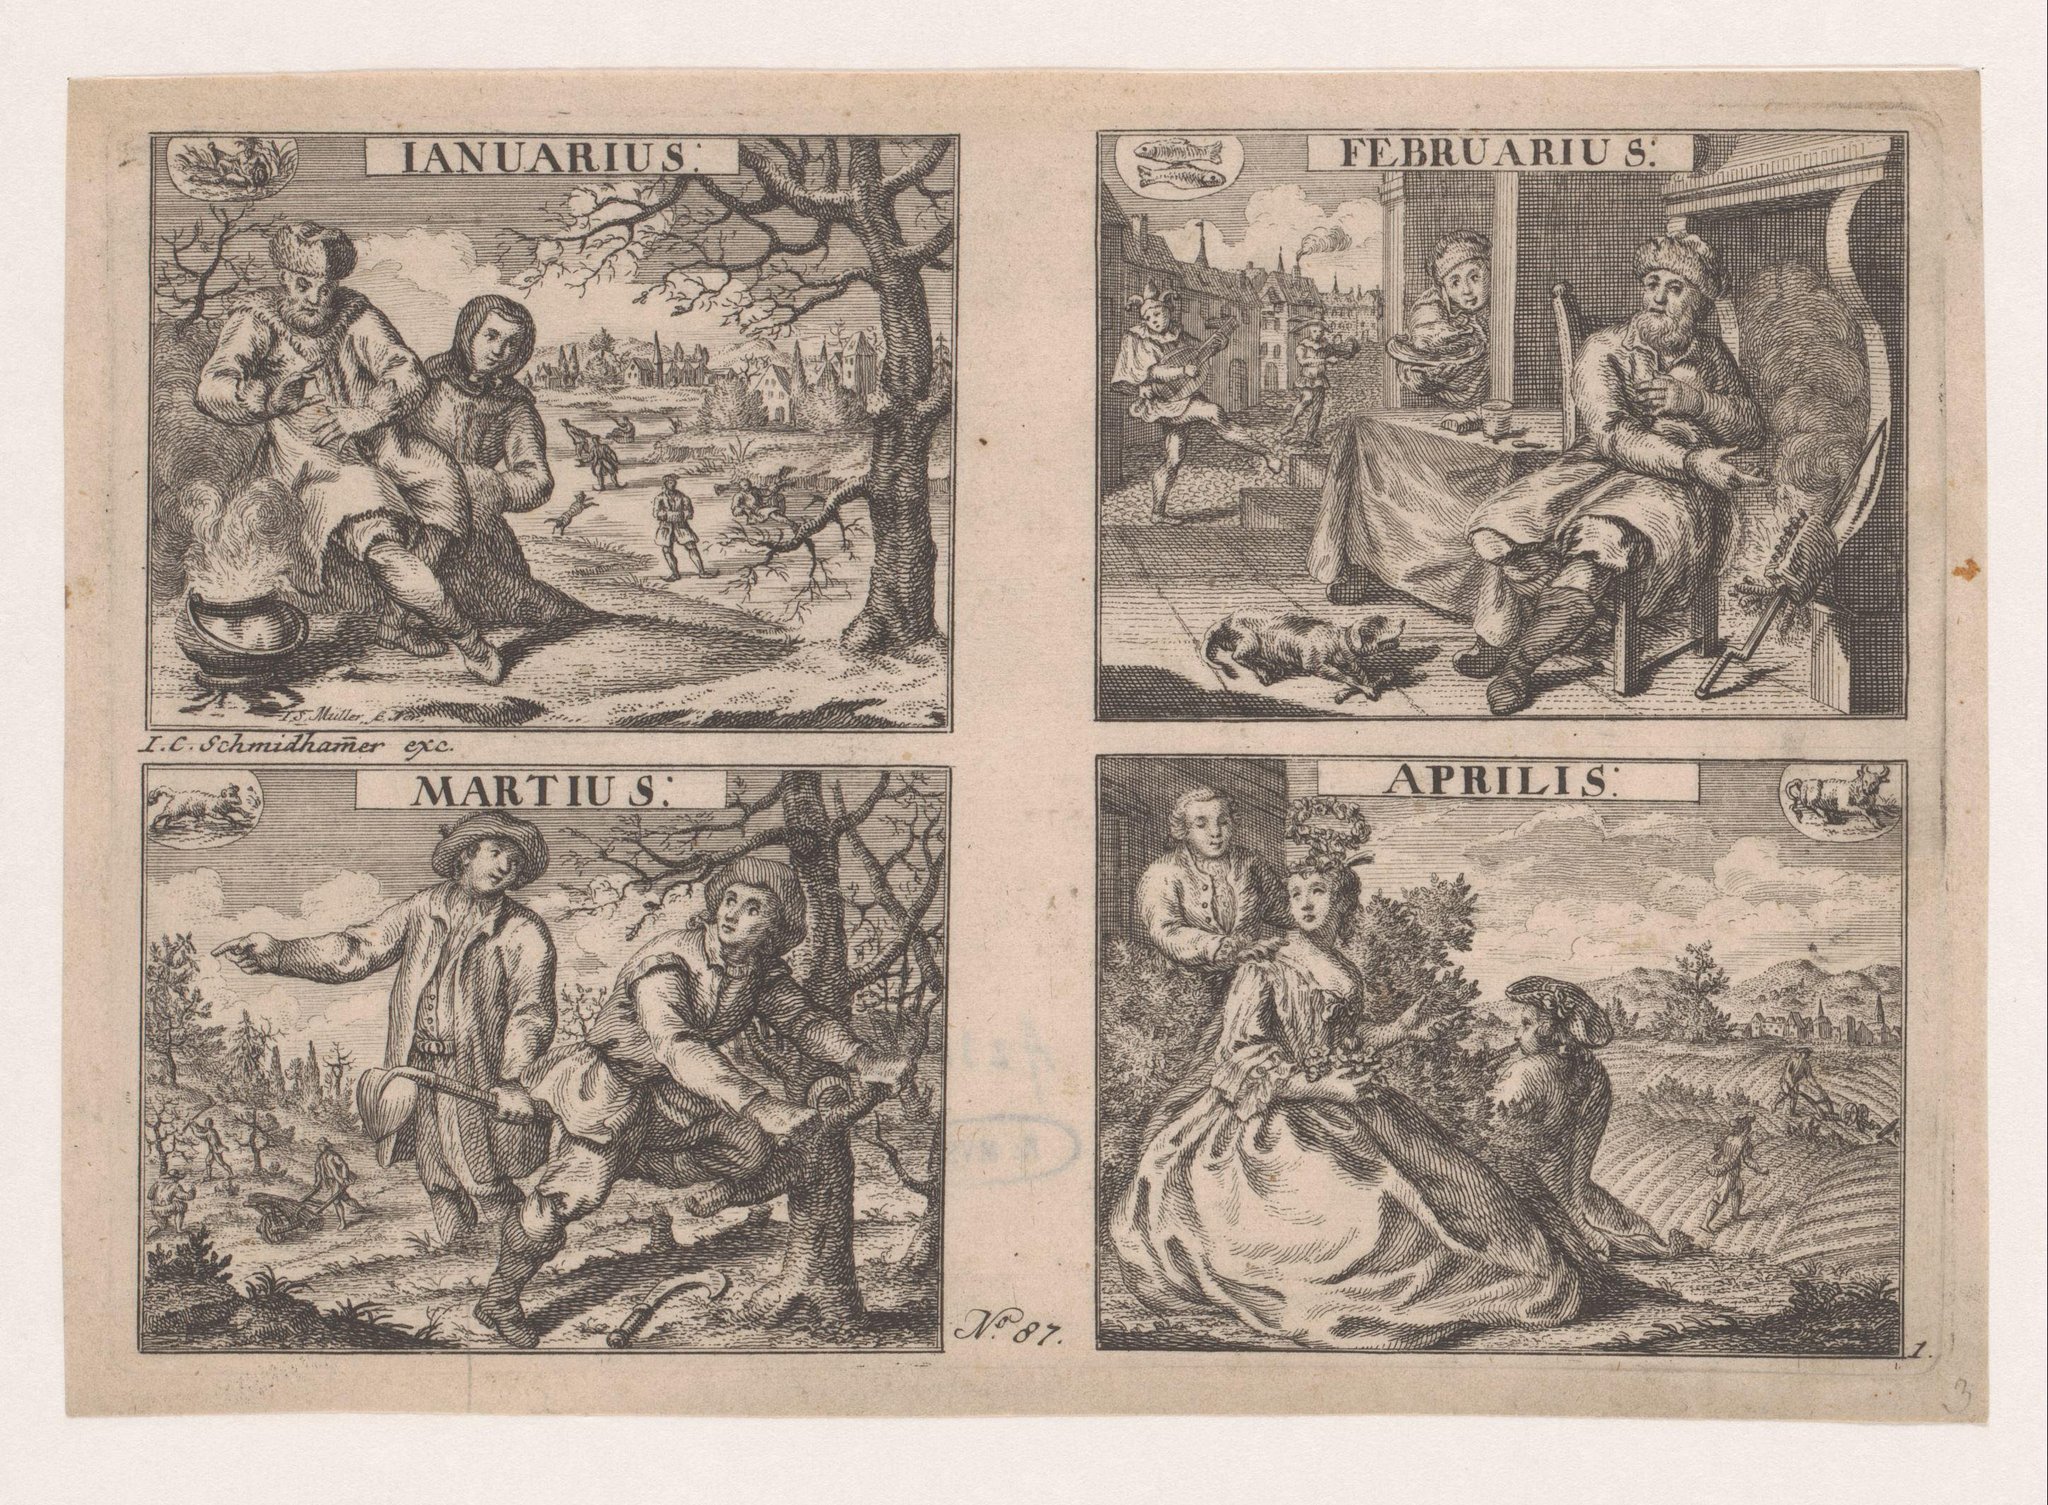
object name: print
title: Januari, februari, maart en april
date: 1700-1799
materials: paper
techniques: etching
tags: taurus (zodiacal sign of april), the twelve months represented by scenes showing human activities, usually in a landscape; so-called 'labours of the months', pisces (zodiacal sign of february), aries (zodical sign of march), aquarius (zodiacal sign of january)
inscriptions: number: ‘No. 87.’, collector's mark: Lugt 2228